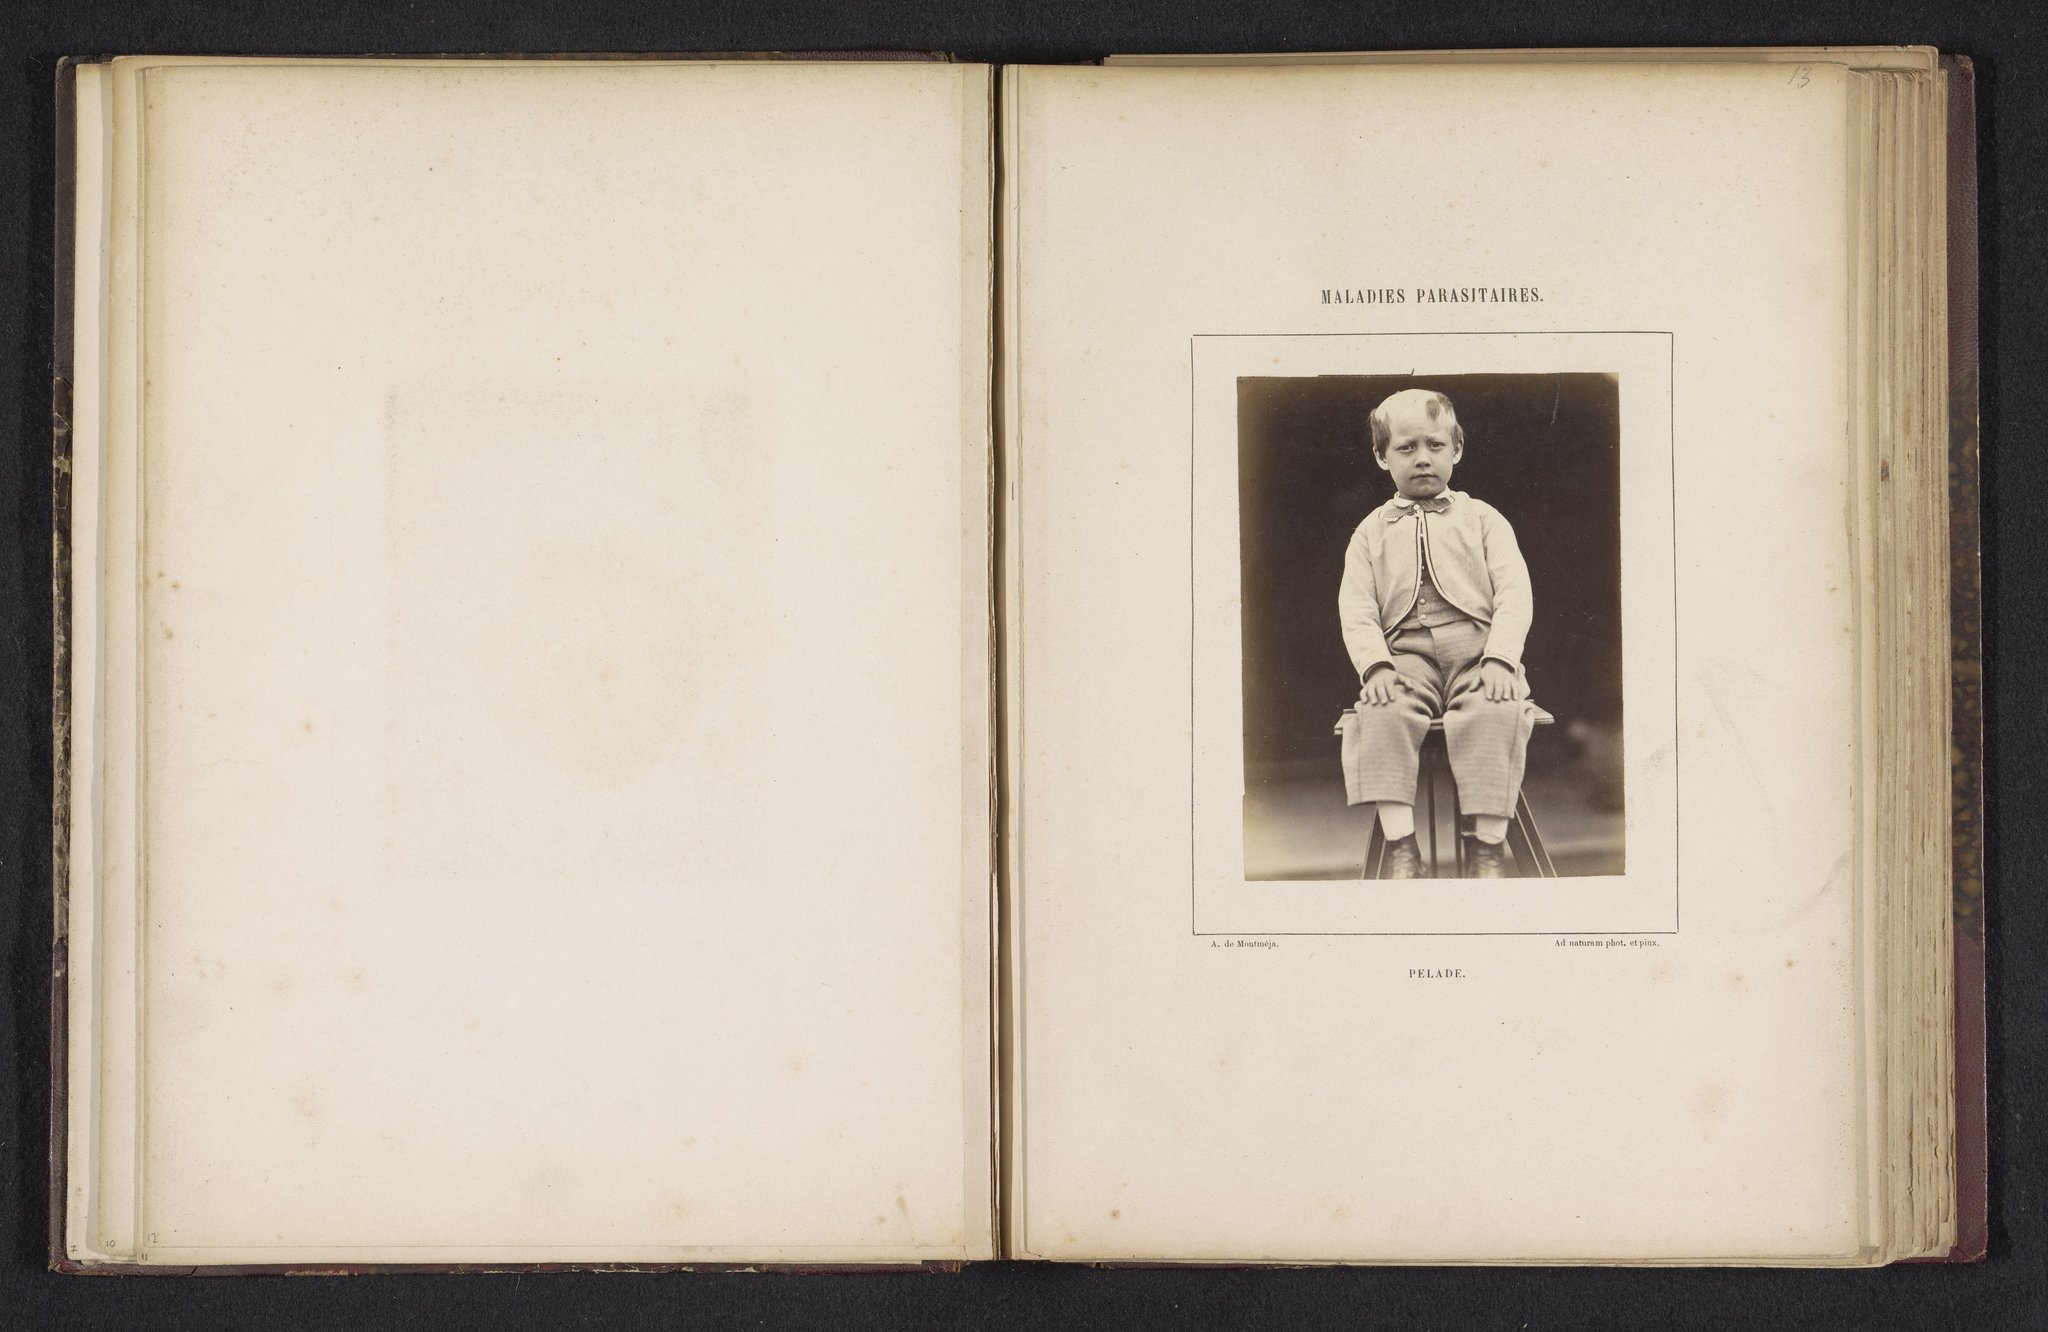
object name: photograph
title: Portret van een onbekende jongen die lijdt aan alopecia areata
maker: a. de montméja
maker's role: arts, fotograaf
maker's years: 1841-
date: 1860-1868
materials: photographic support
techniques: albumen print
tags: skin and venereal diseases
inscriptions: number: ‘13’, inscription: ‘Maladies parasitaires.’, inscription: ‘Ad naturam phot. et pinx.’